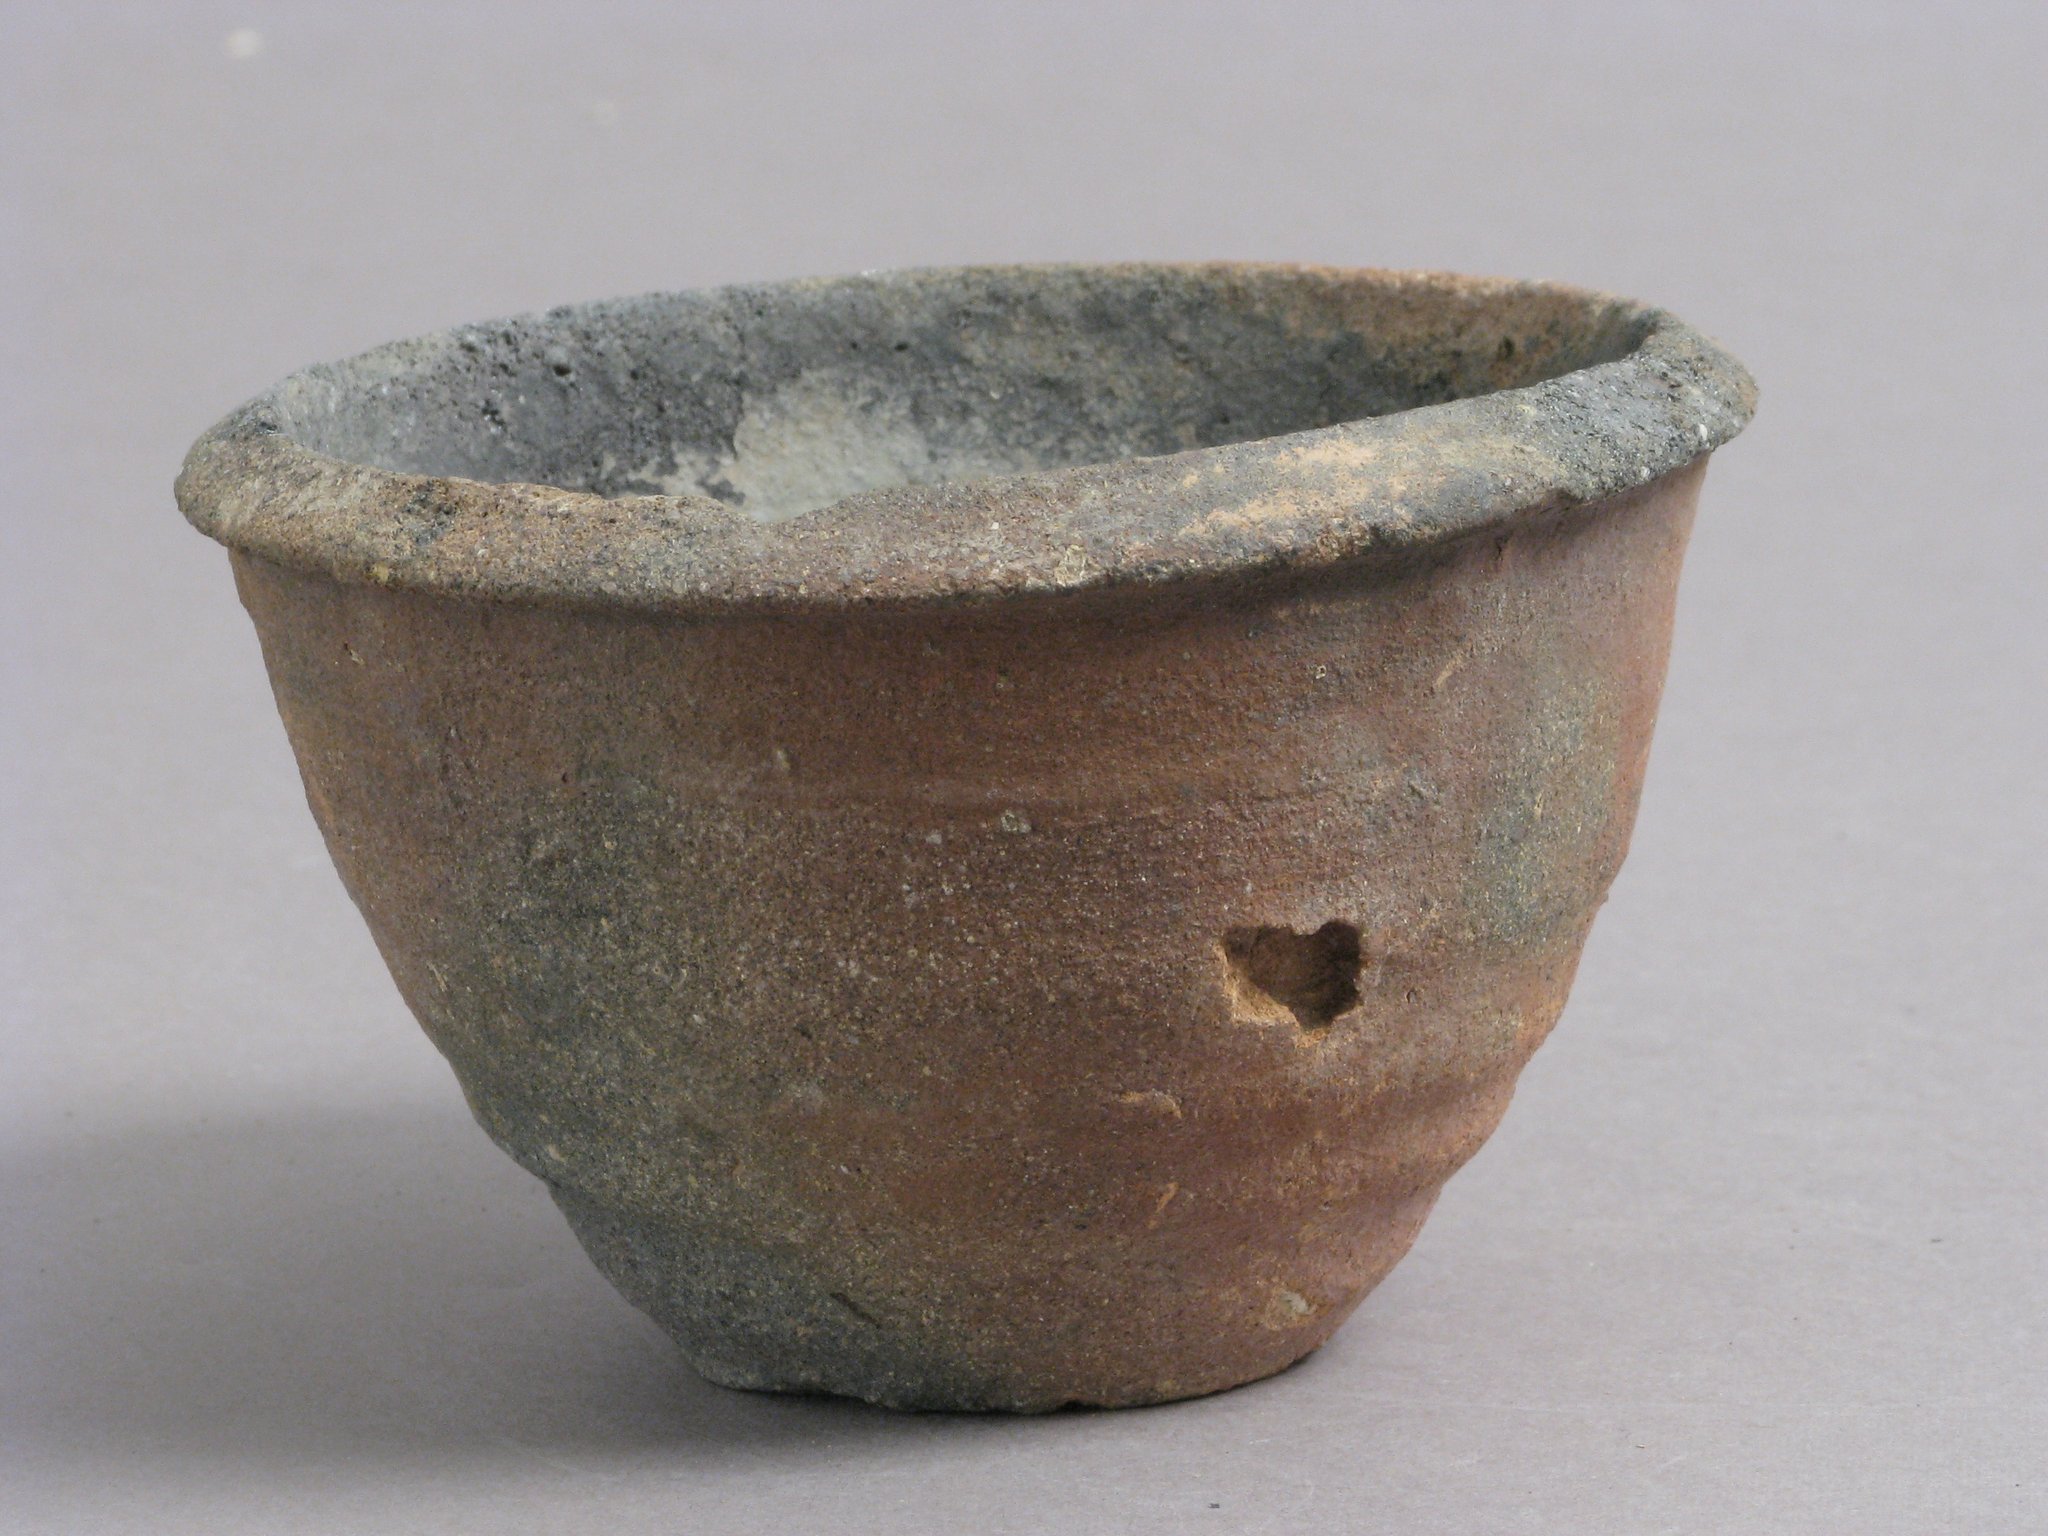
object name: bowl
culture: coptic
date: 301-700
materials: earthenware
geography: egypt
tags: bowls